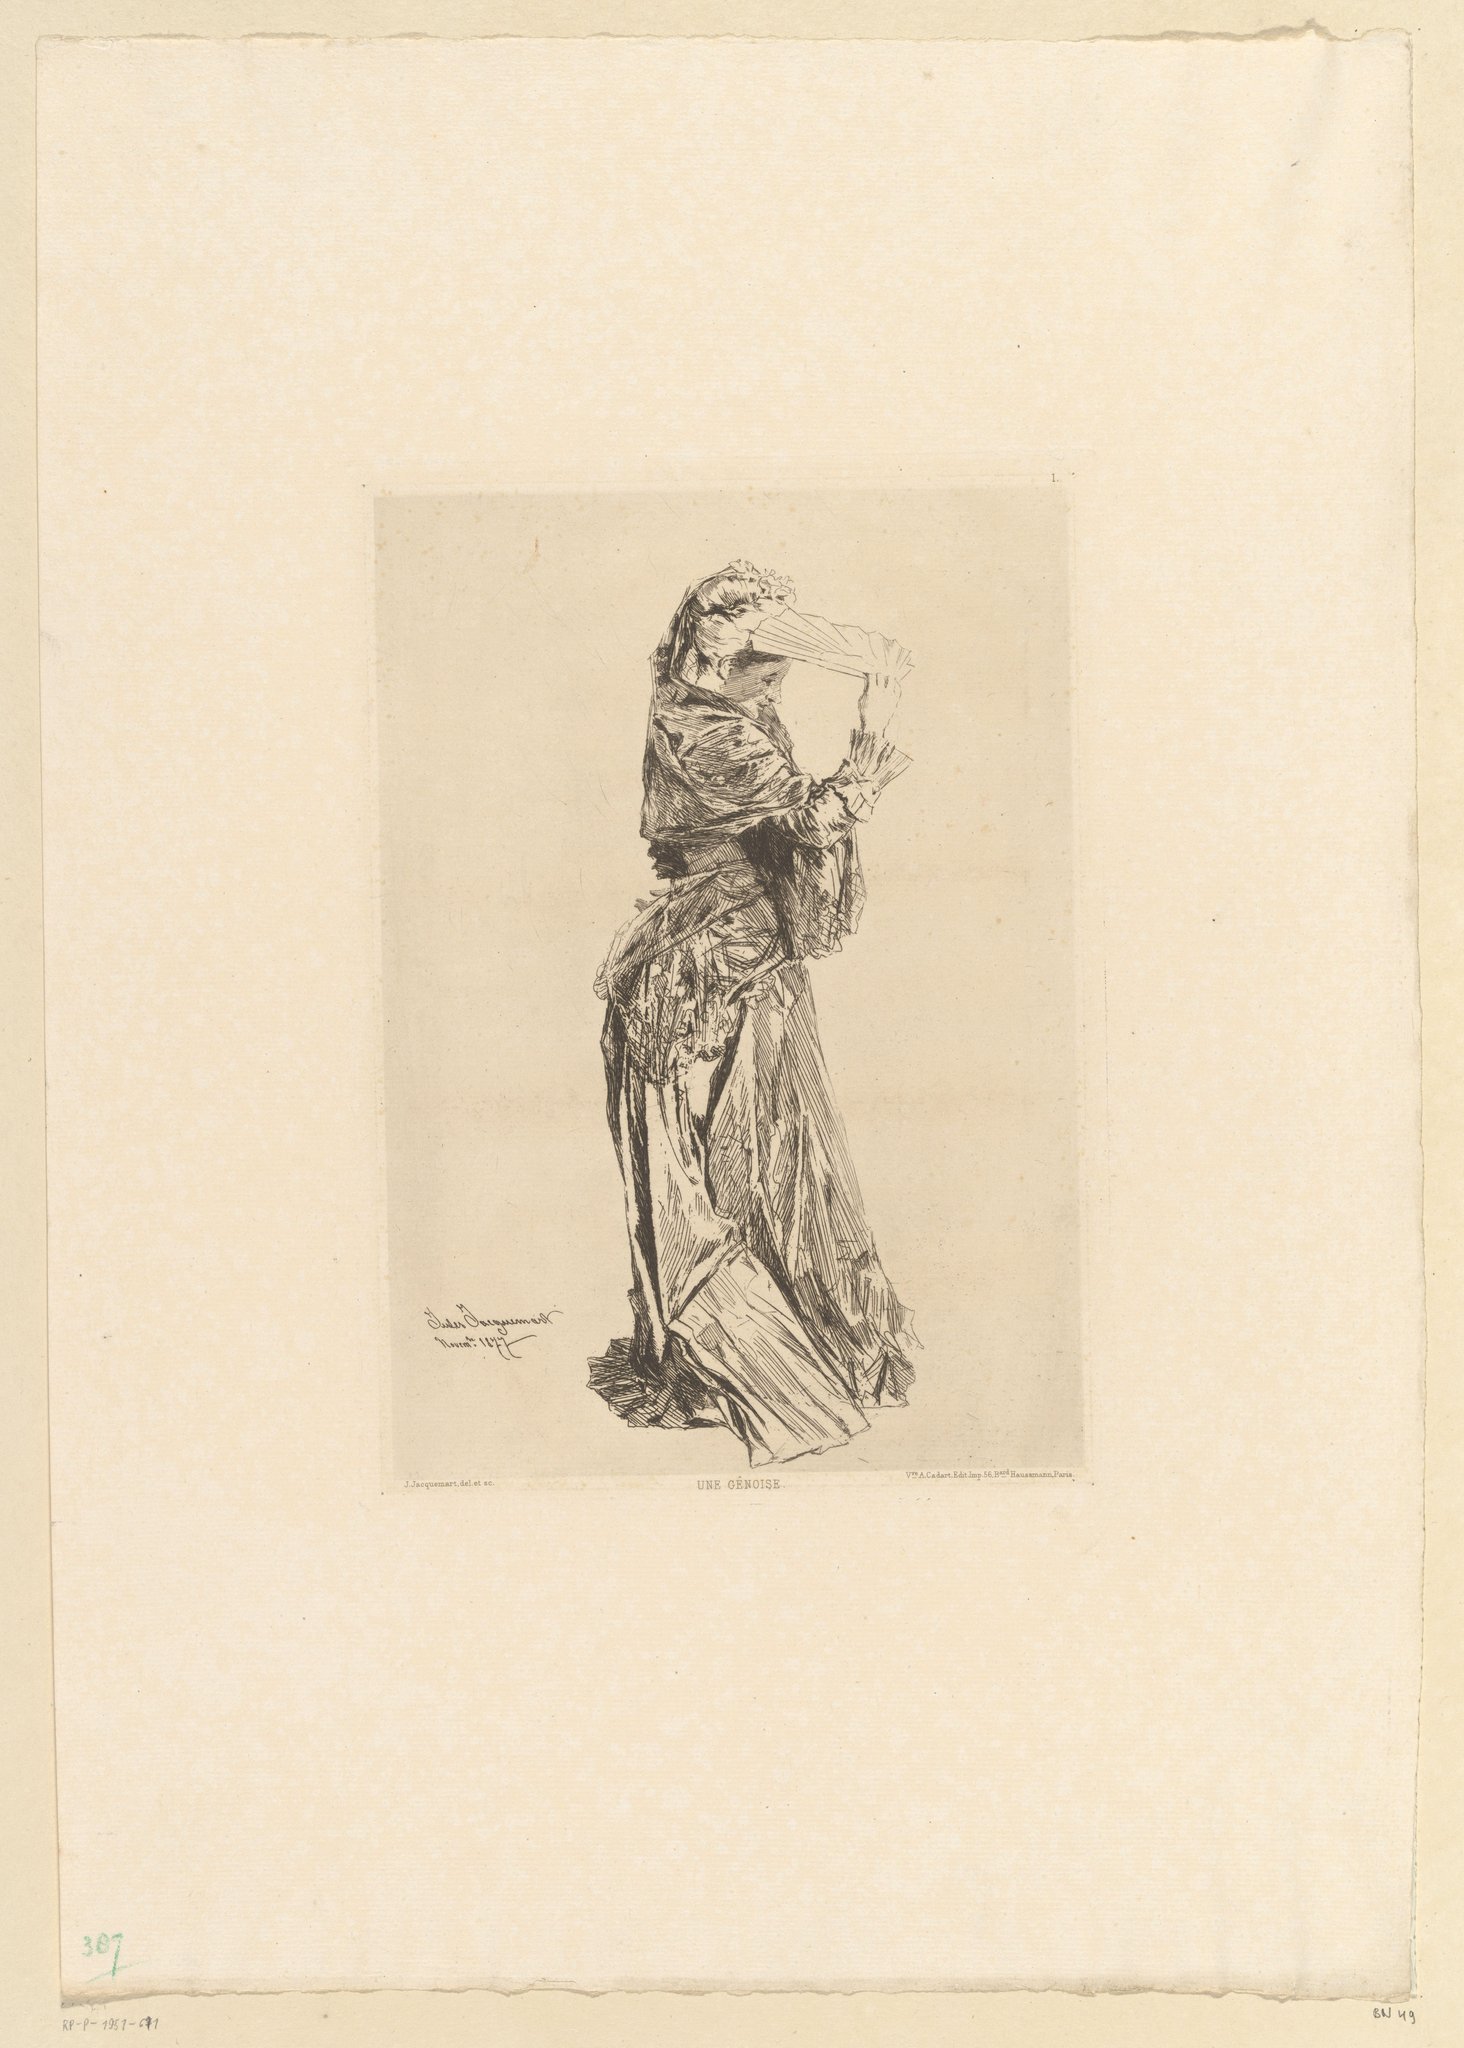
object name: print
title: Staande vrouw met waaier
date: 1877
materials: paper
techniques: drypoint, etching, intaglio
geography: france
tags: adult woman, fan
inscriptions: collector's mark: Lugt 2228